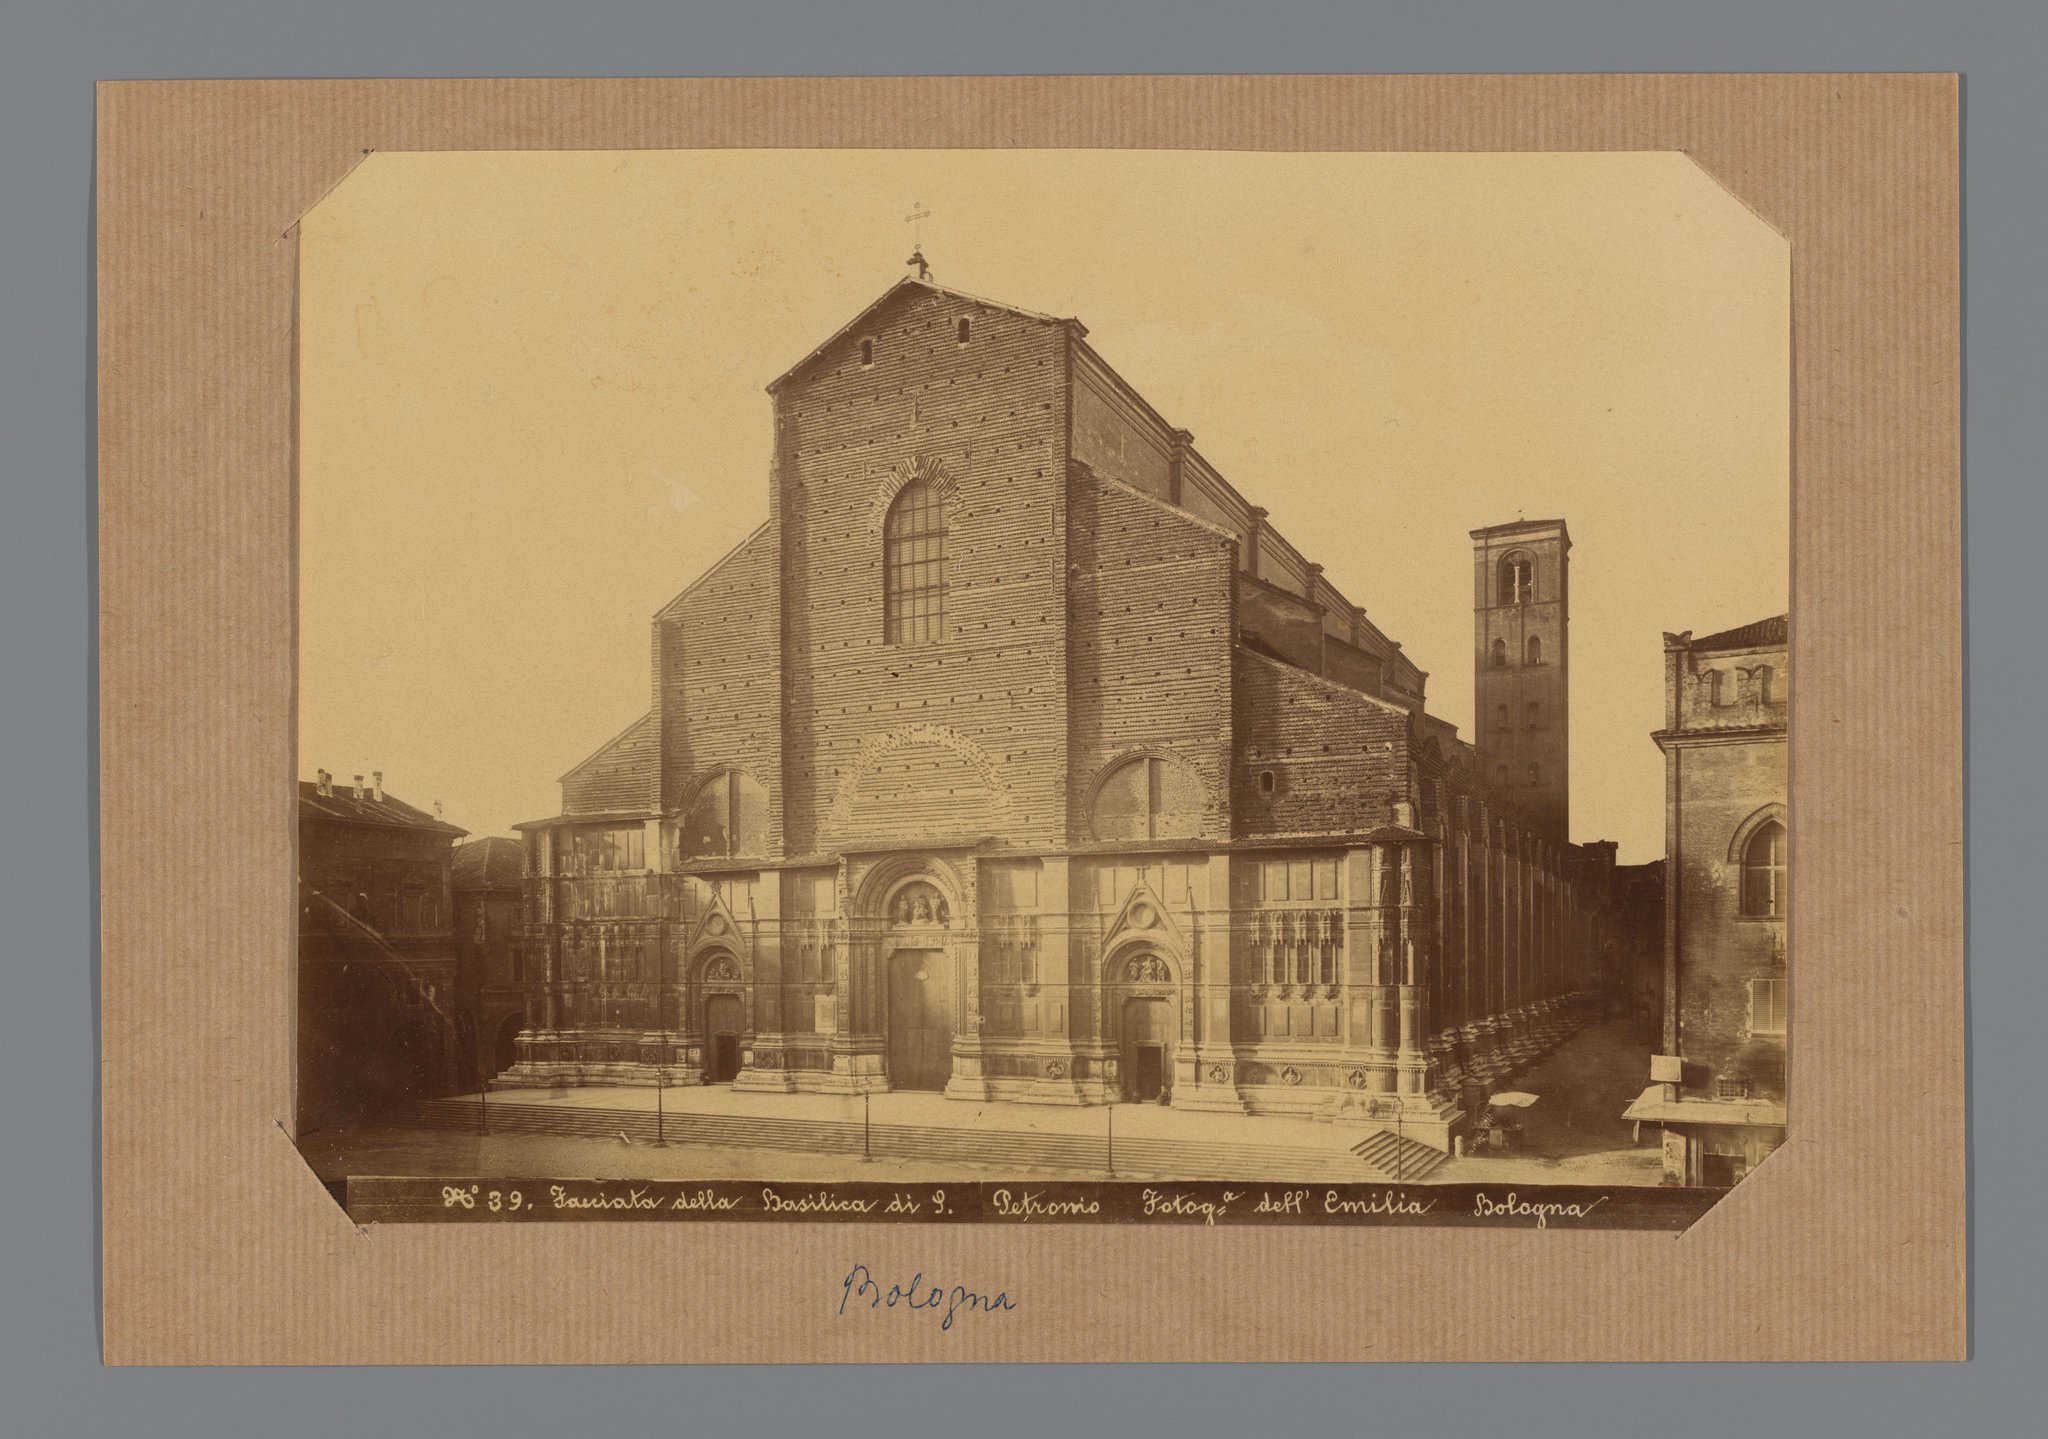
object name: photograph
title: Italië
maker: Anonymous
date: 1880-1910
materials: photographic support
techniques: albumen print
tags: italy